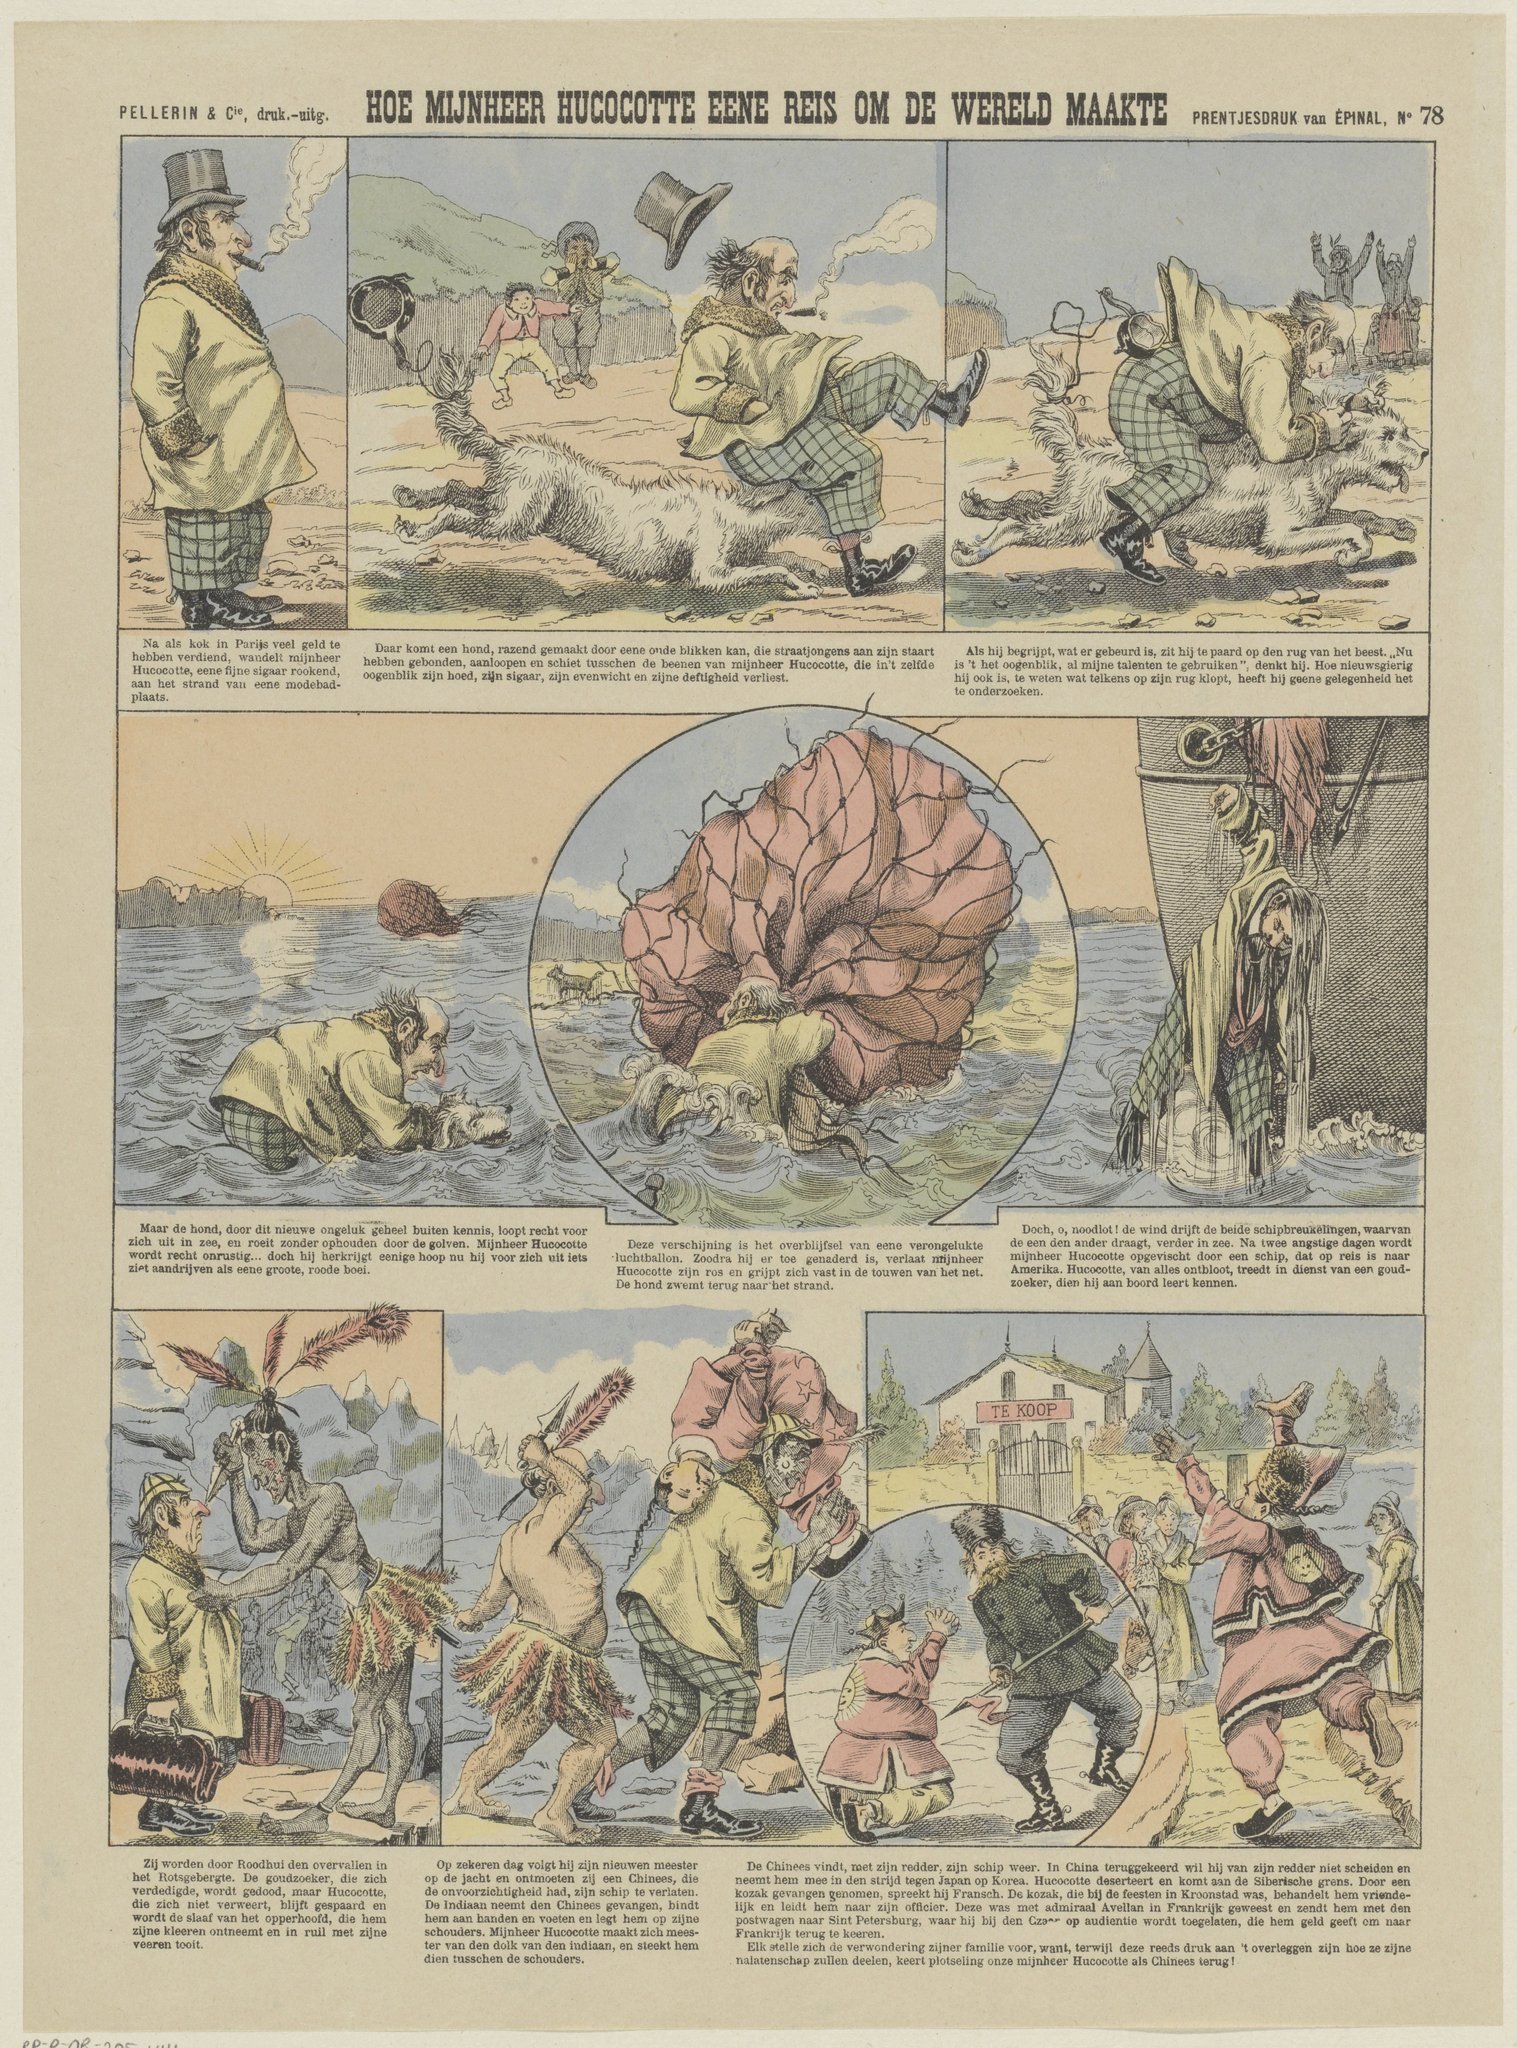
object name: popular print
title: Prentjesdruk van Epinal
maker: Anonymous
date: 1902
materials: paper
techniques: colour, letterpress printing, lithograph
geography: epinal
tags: chinese, world tour, e.g.: world cruise, saving a person from drowning (+ variant), indigenous peoples of north america, travelling; tourism, dog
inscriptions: collector's mark: Lugt 2760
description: Blad met tien voorstellingen over meneer Hucocotte die een wereldreis maakt. Onder elke afbeelding een onderschrift. Genummerd rechtsboven: No 78.